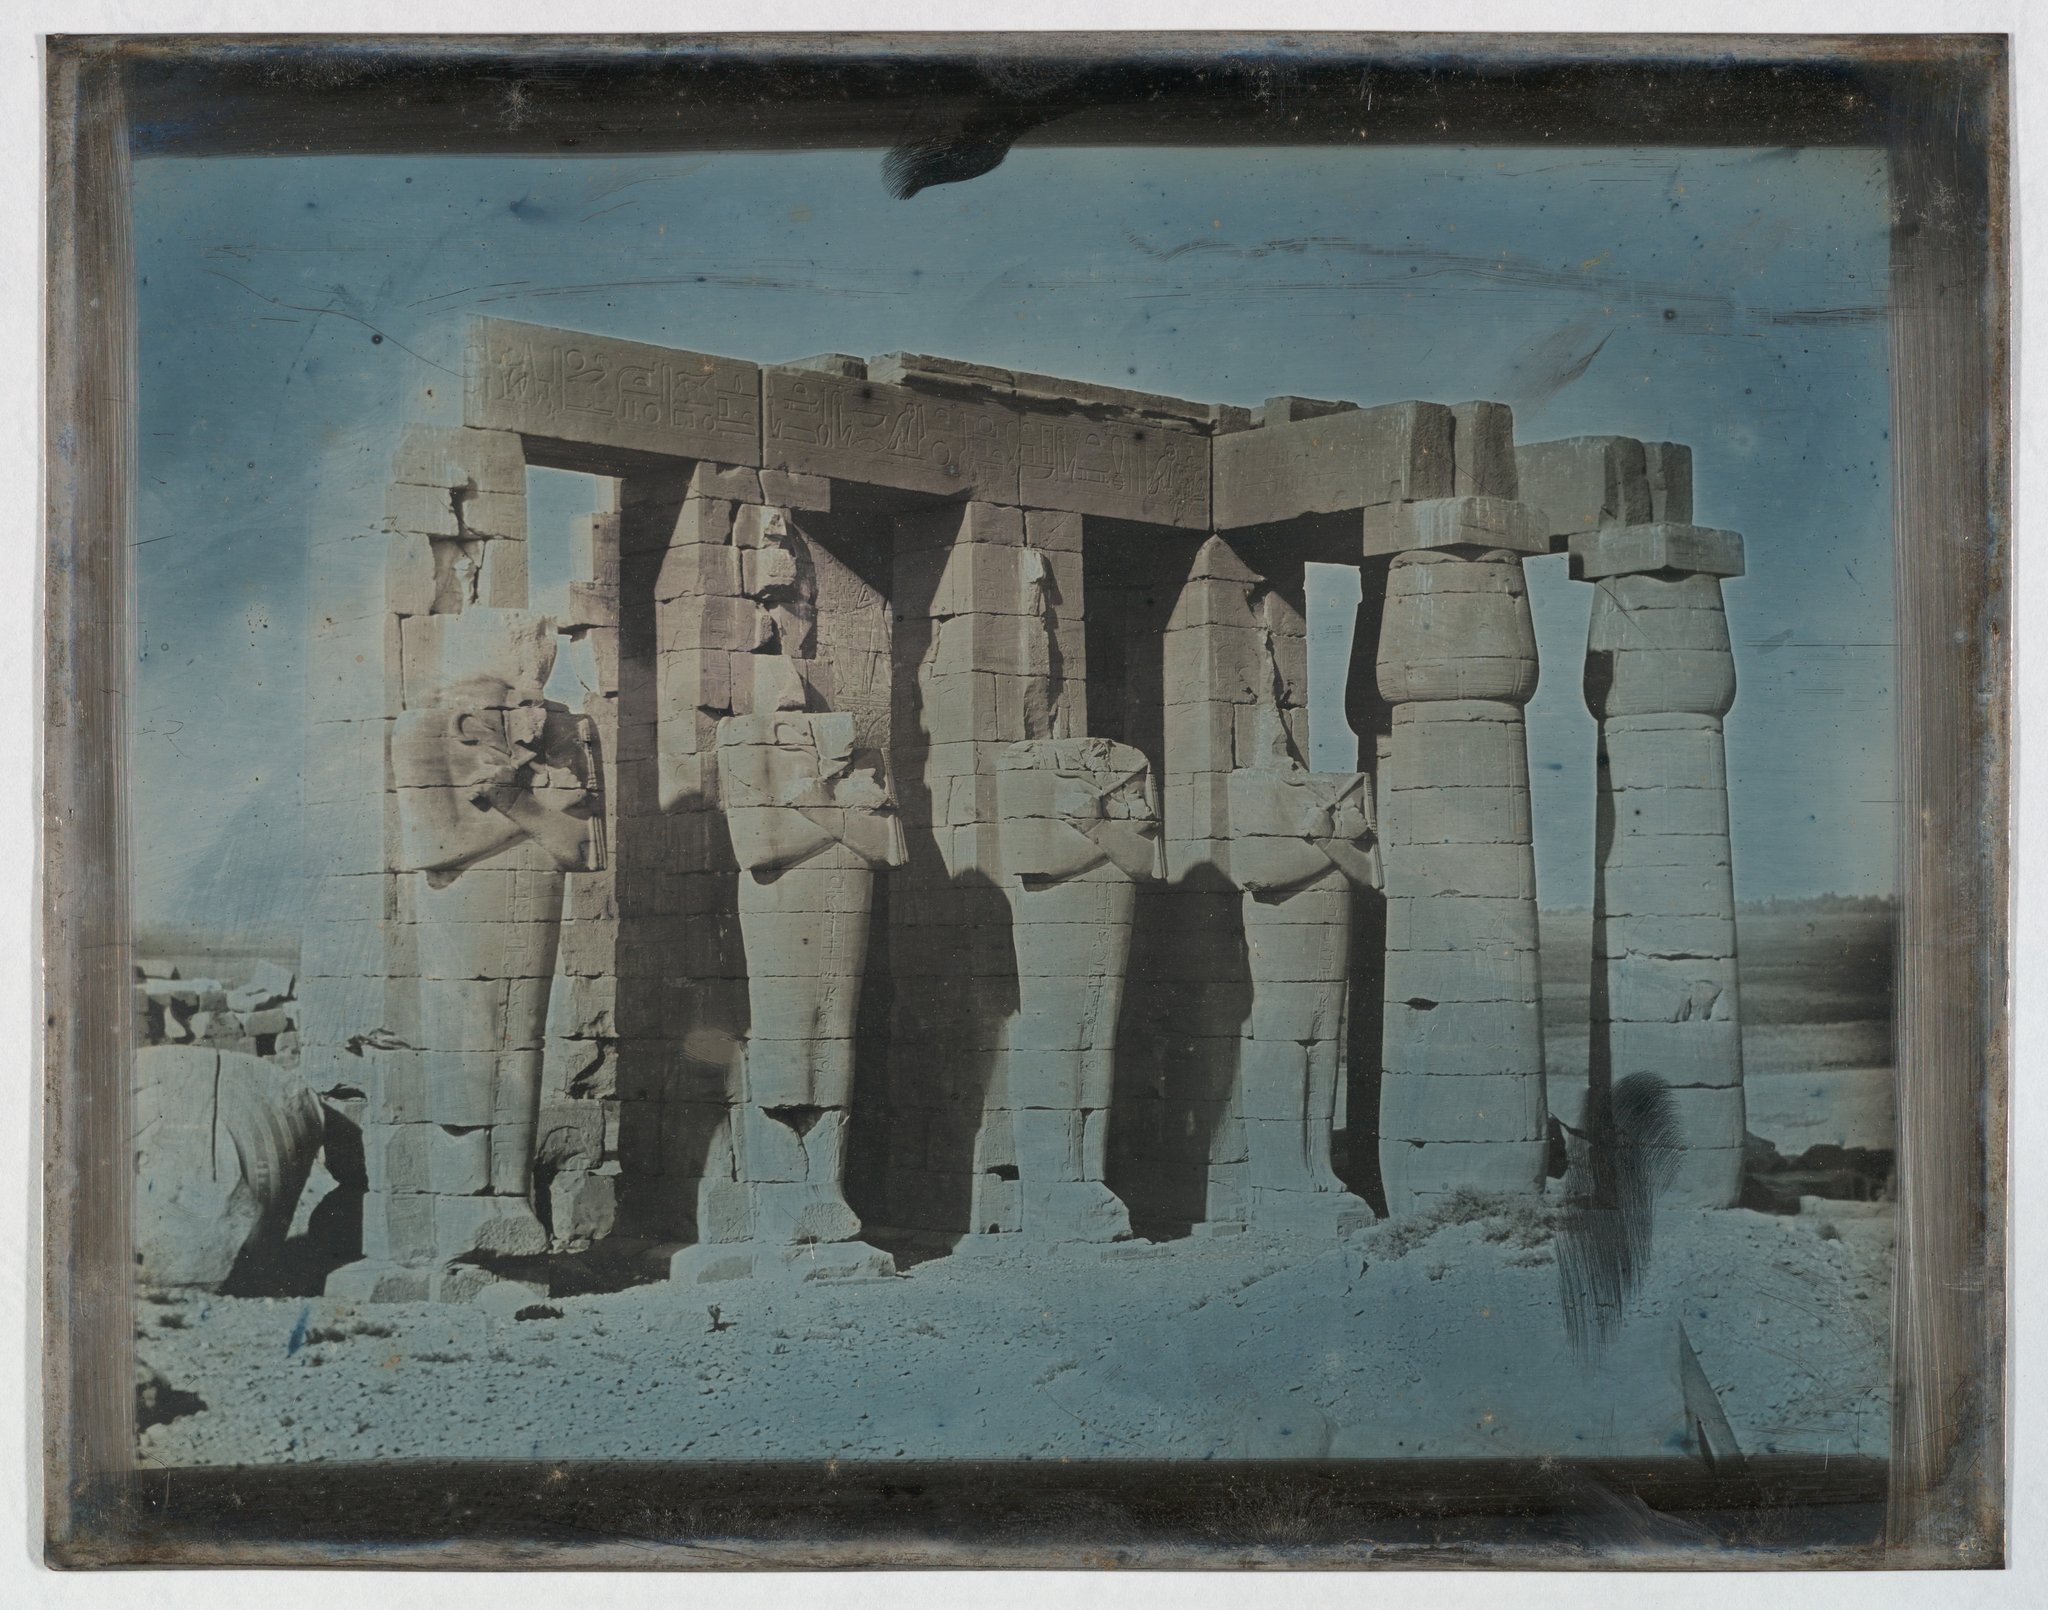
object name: photograph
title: Ramesseum, Thebes (201. Thèbes. 1844. 202 Rhamséion.)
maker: joseph-philibert girault de prangey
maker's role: artist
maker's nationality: french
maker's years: 1804-1892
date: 1844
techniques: daguerreotype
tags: architecture,ruins